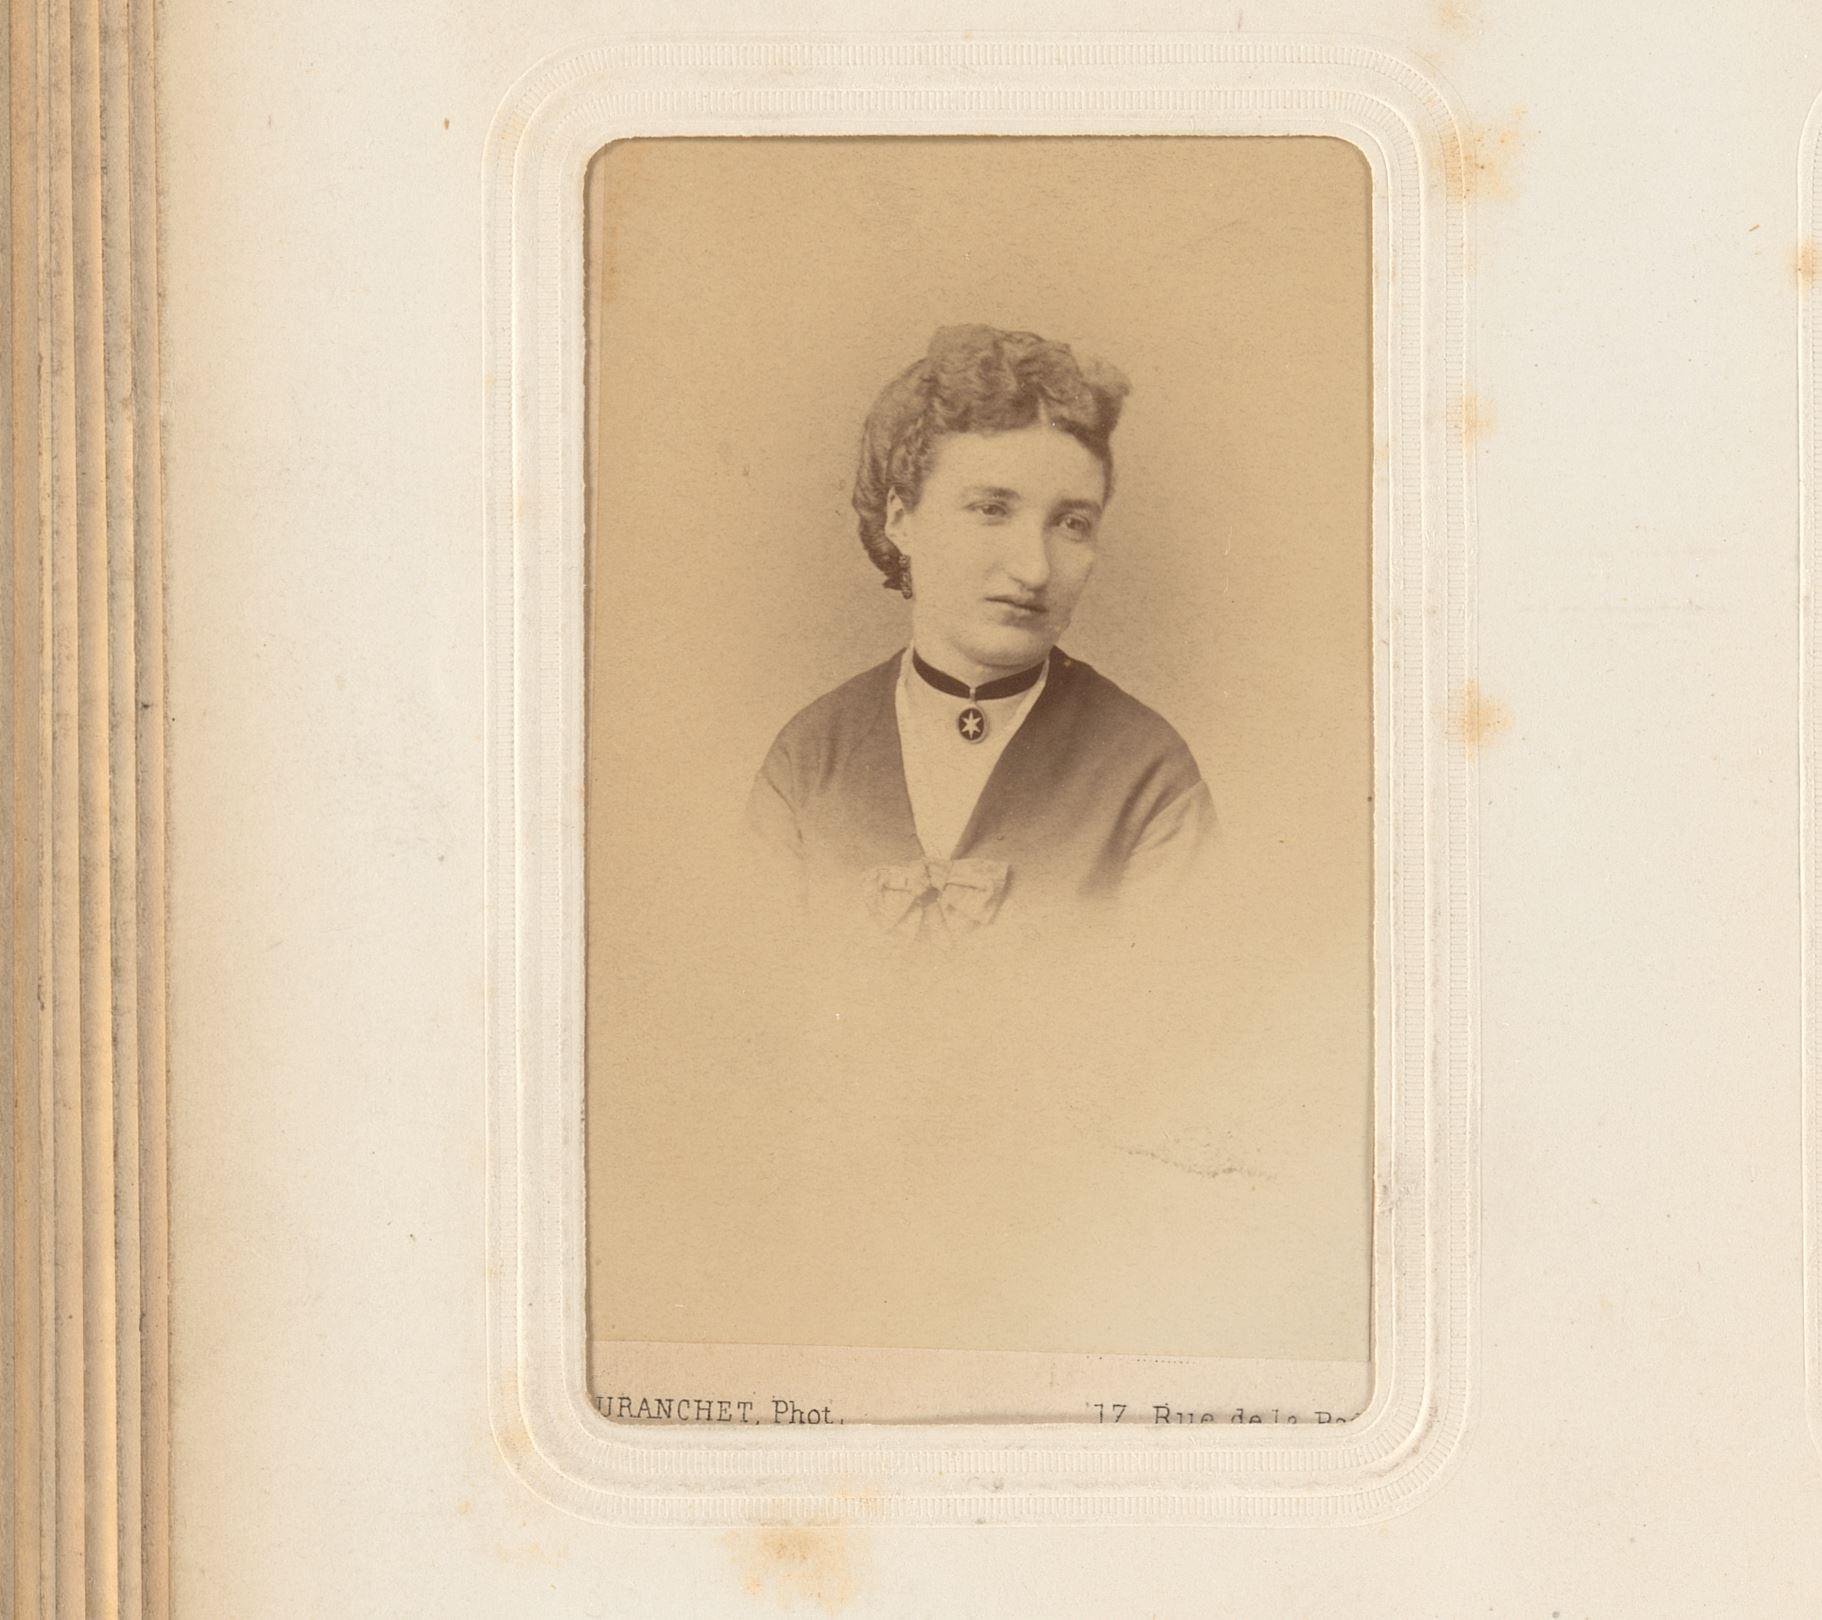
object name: carte de visite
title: Portret van een vrouw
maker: françois touranchet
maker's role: fotograaf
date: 1868-1875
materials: cardboard, paper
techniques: albumen print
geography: paris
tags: historical persons - bb - woman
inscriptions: address: ‘17, Rue de la Paix’, inscription: ‘TF/ TOURANCHET/ PHOTOGRAPHE/ 17, Rue de la Paix, 17,/ PARIS/ Les Clichés étant conservés l'on peut toujours obtenir/ de nouvelles Epreuves. Il suffit de donner le nom.’